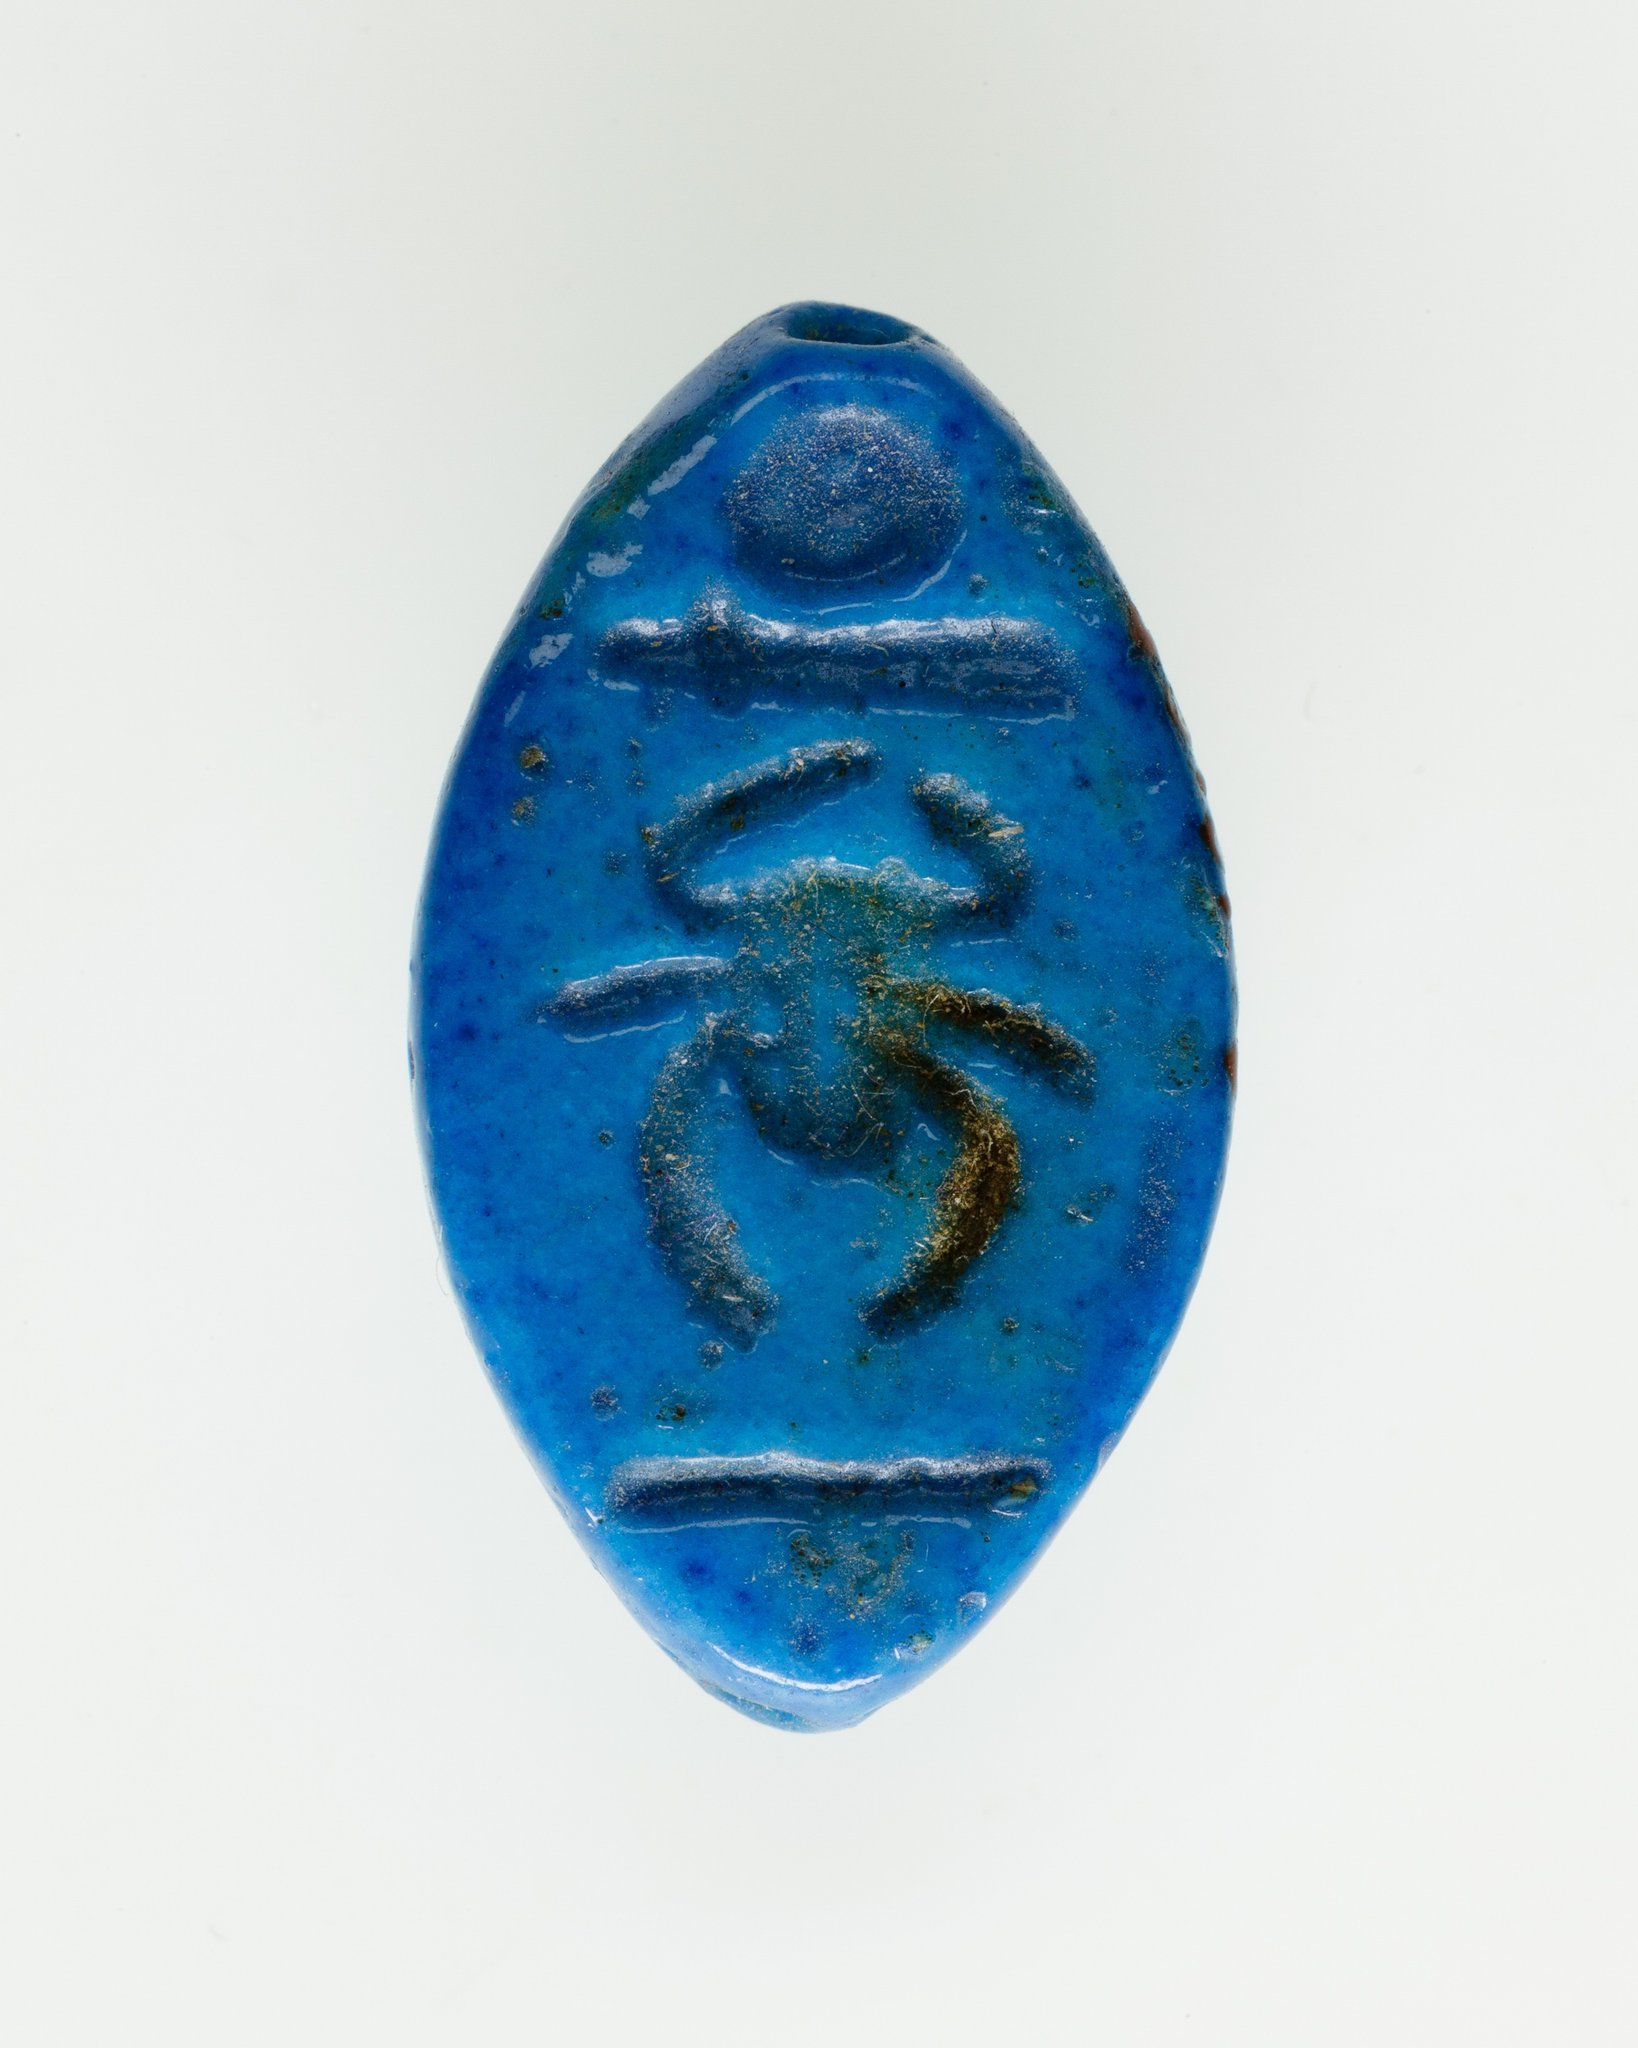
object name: cowroid, thutmose ii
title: Cowroid Seal-Amulet Inscribed with the Throne Name of Thutmose II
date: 1492-1479 BCE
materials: faience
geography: egypt